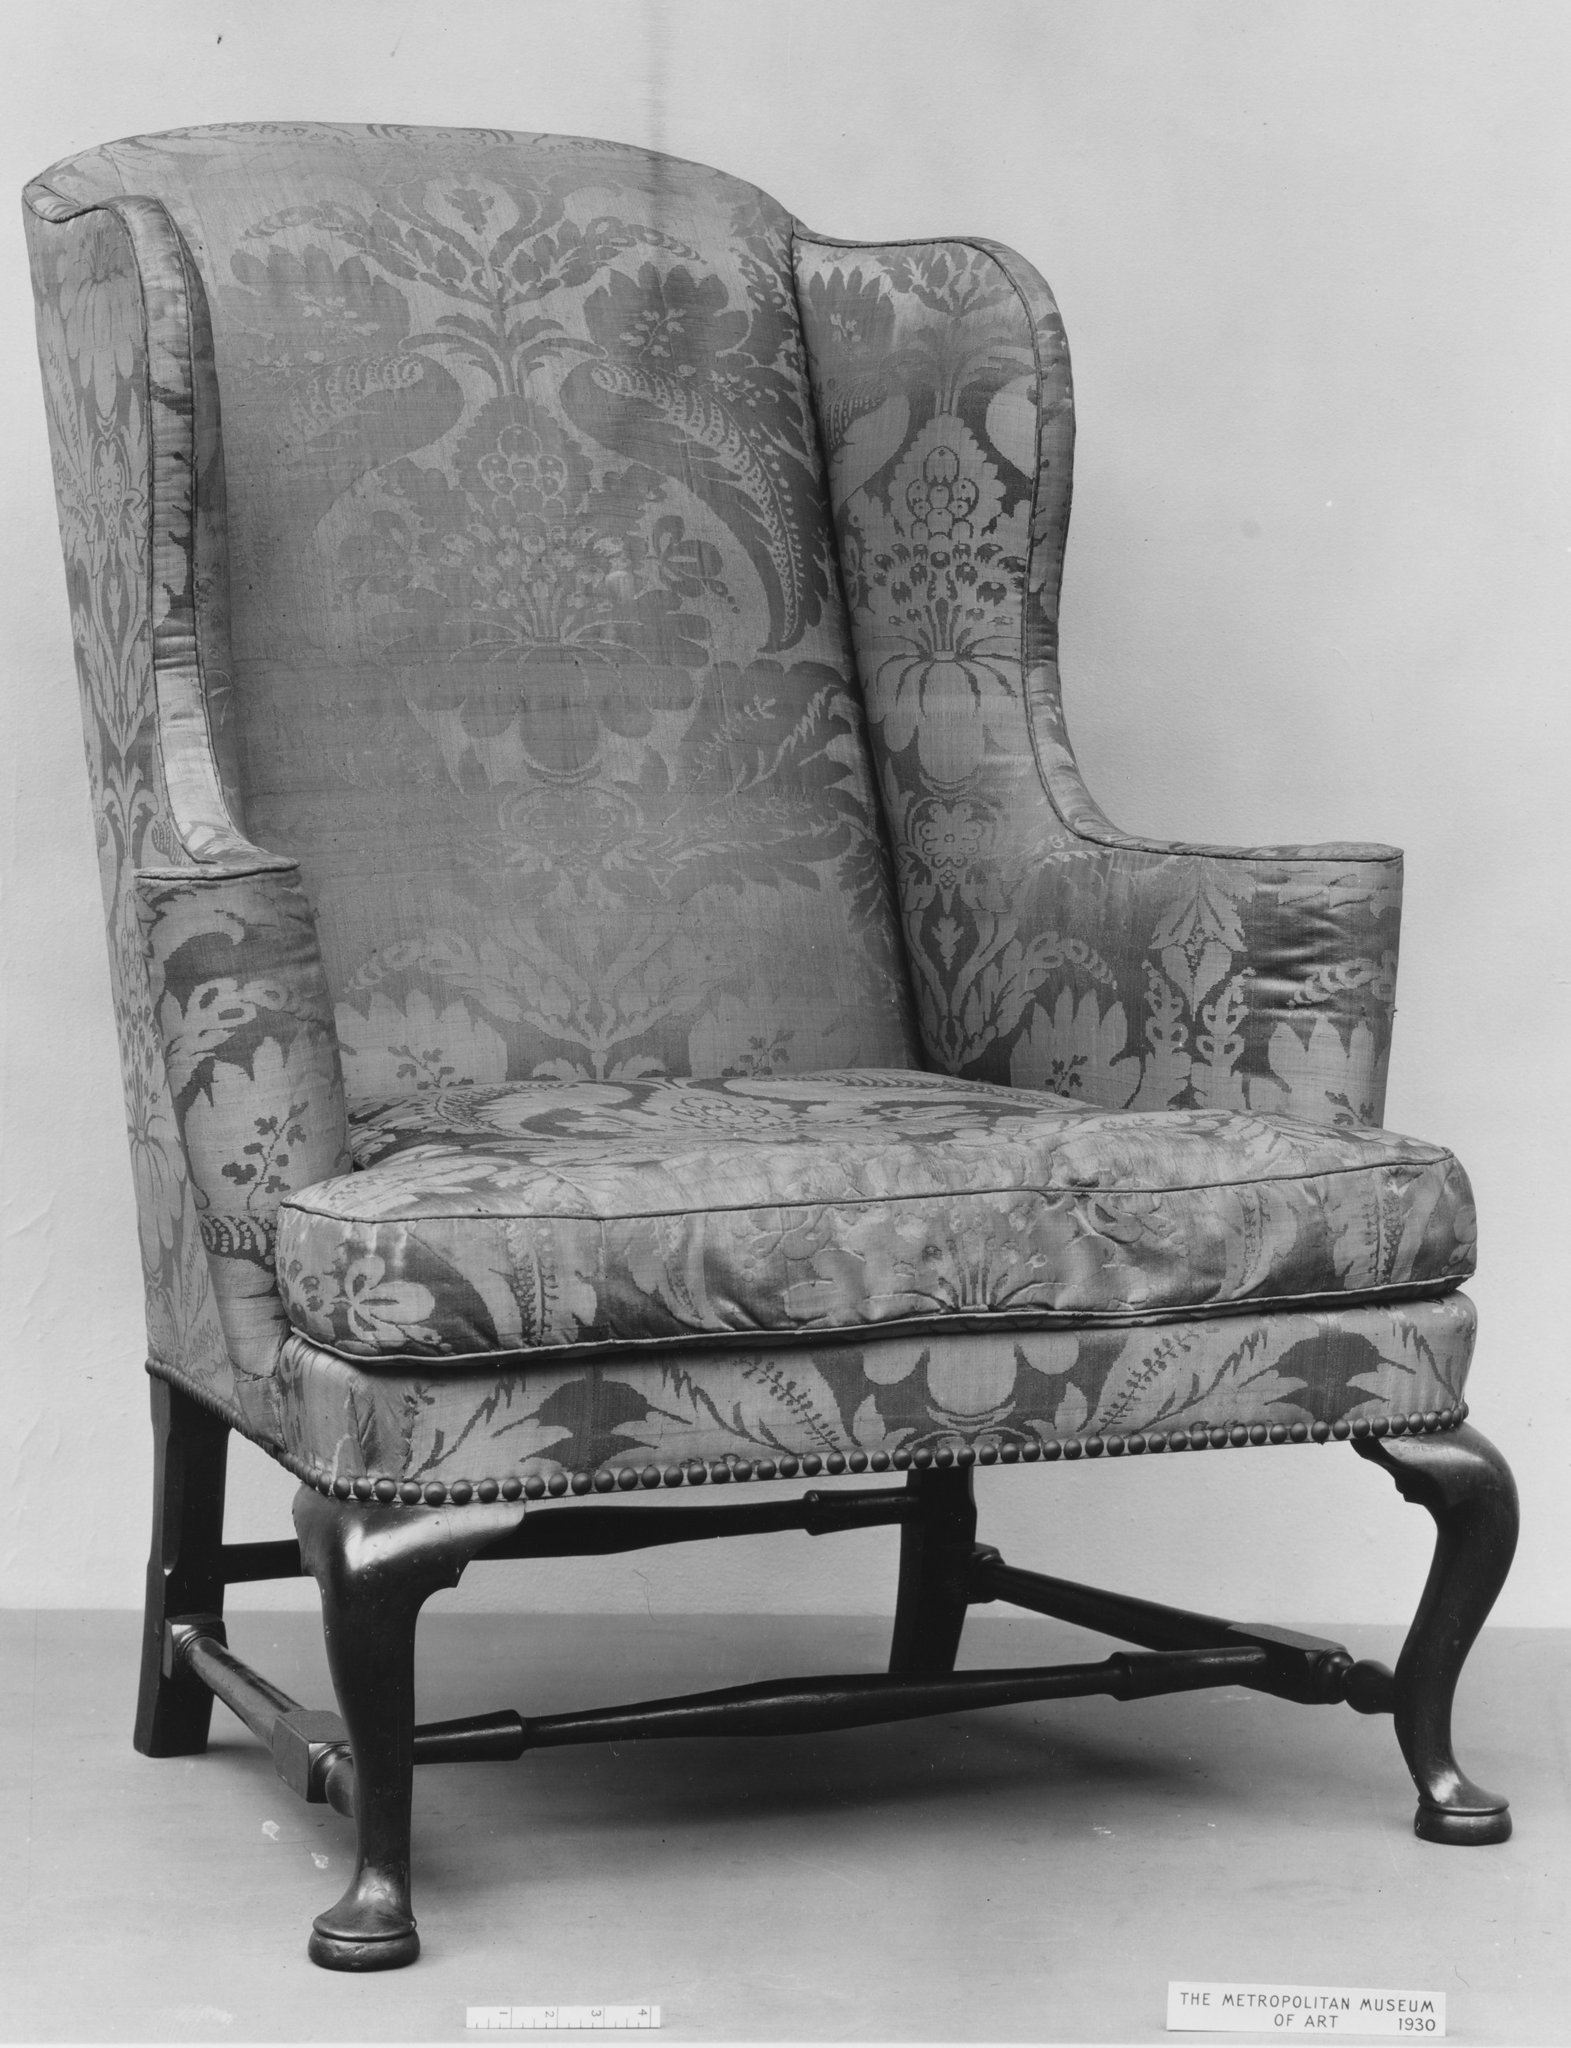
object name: easy chair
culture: american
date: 1730-1790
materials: wood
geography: united states